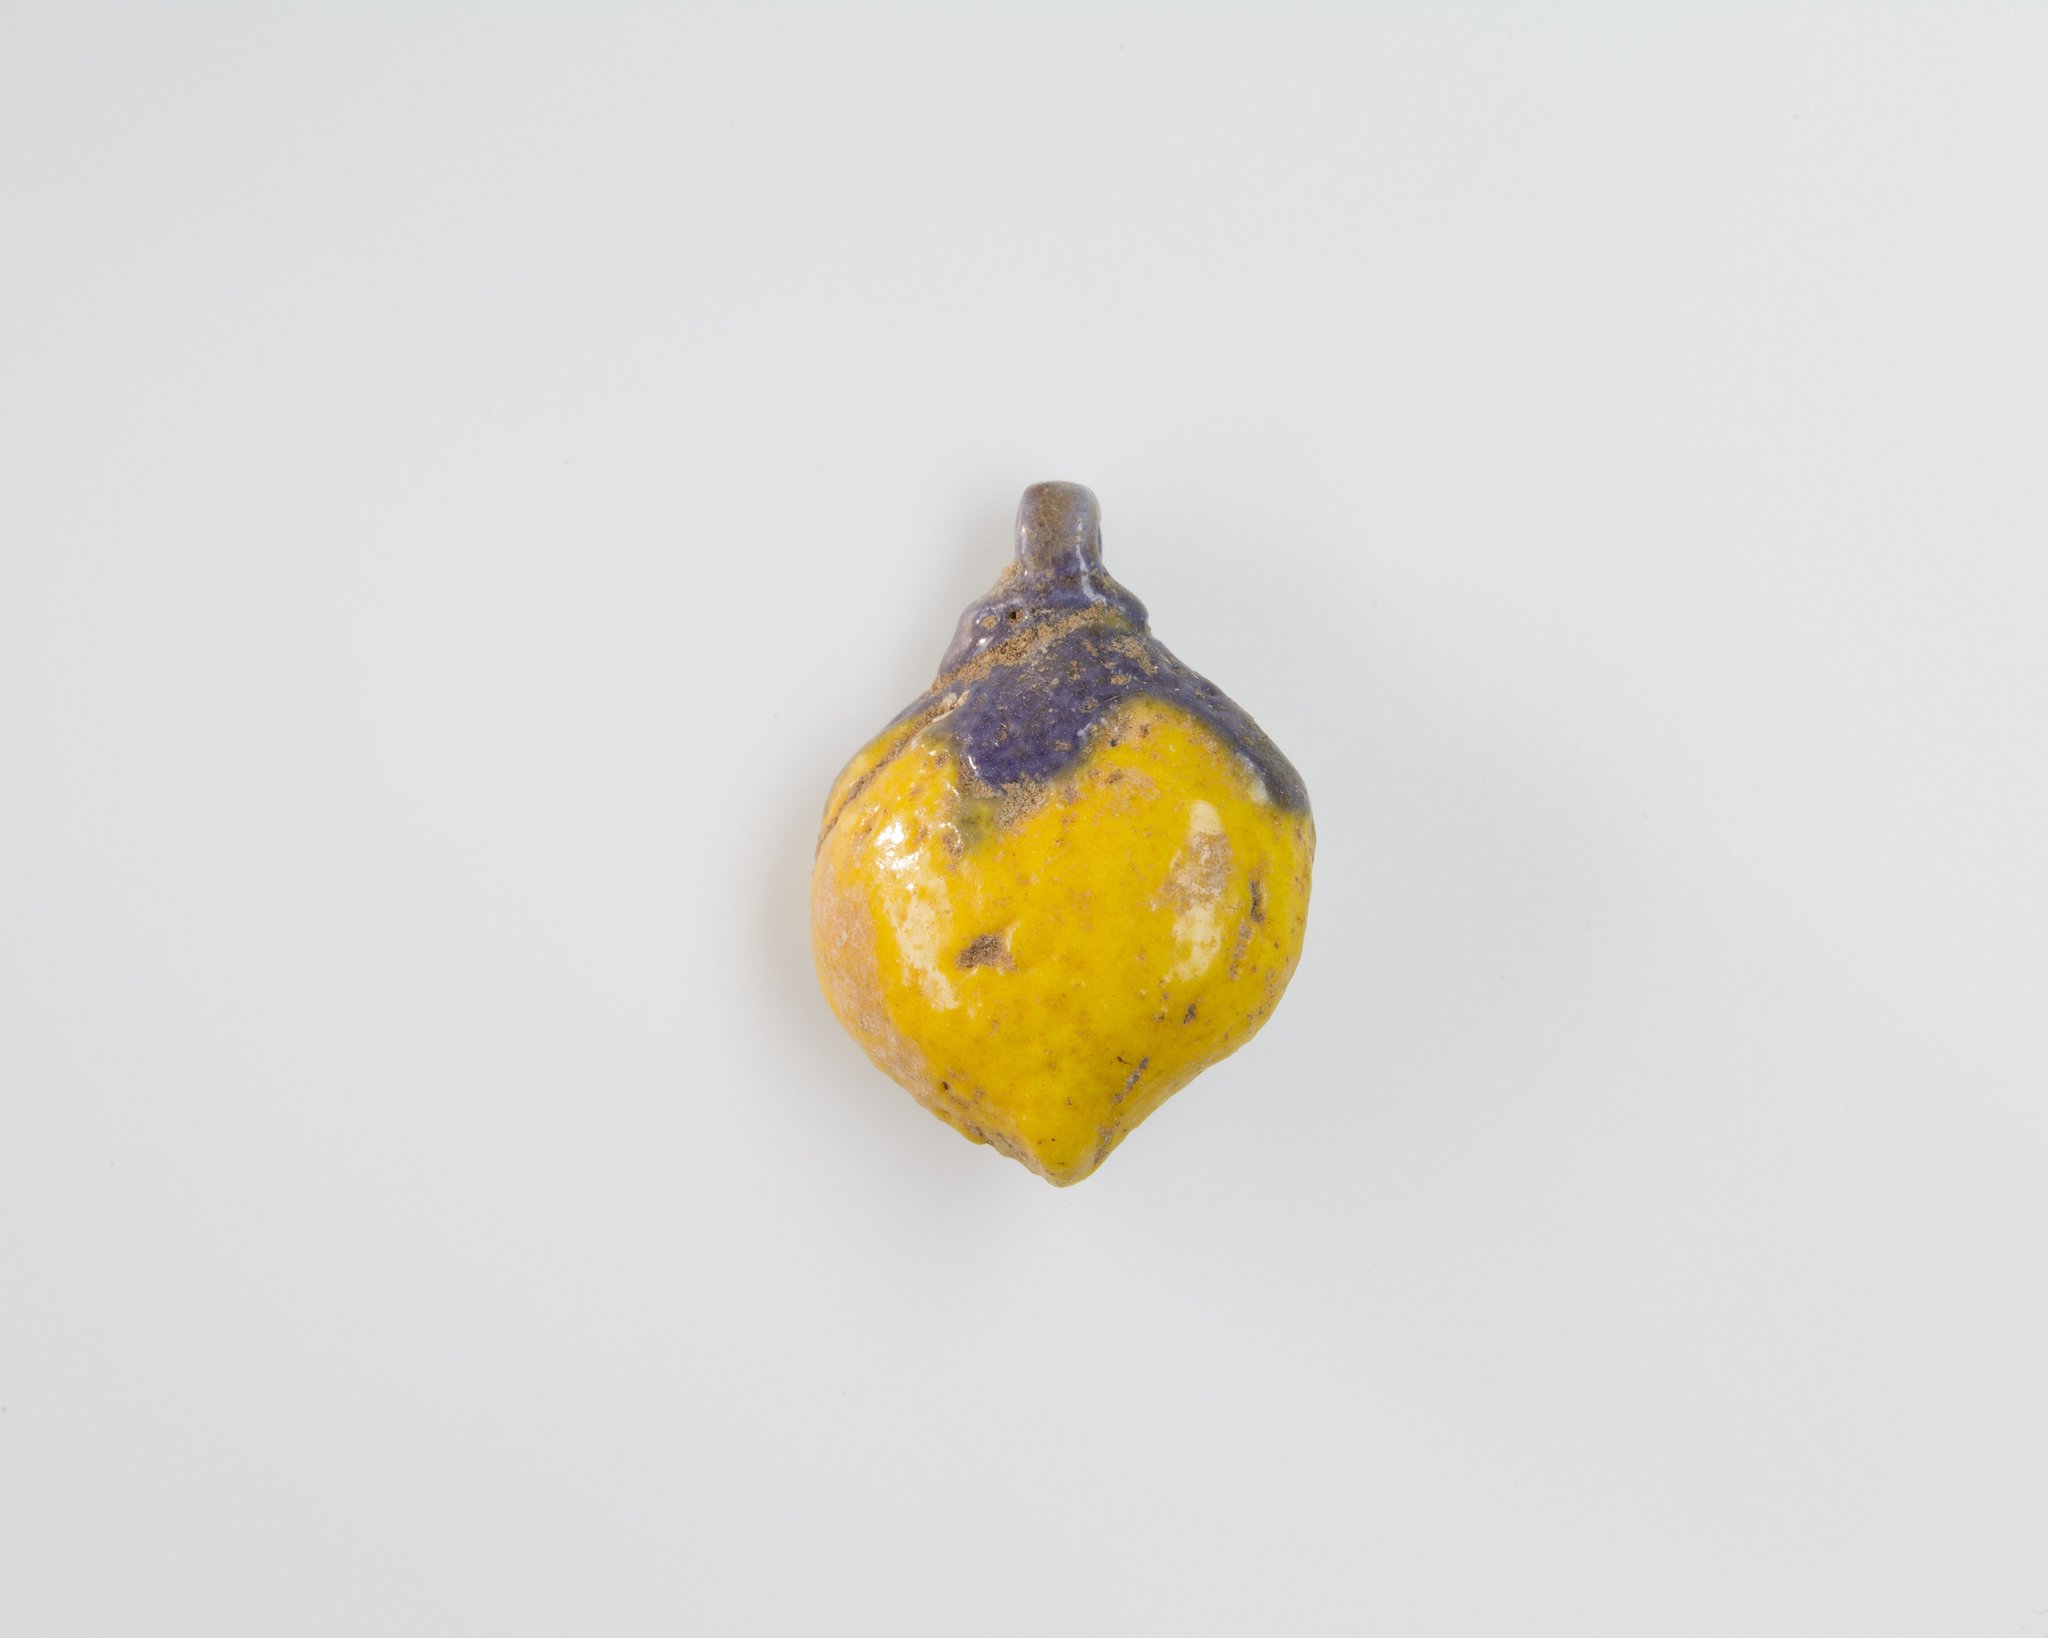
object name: beadt, mandrake fruit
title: Bead in the Form of a Mandrake Fruit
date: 1390-1352 BCE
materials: faience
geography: egypt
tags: fruit